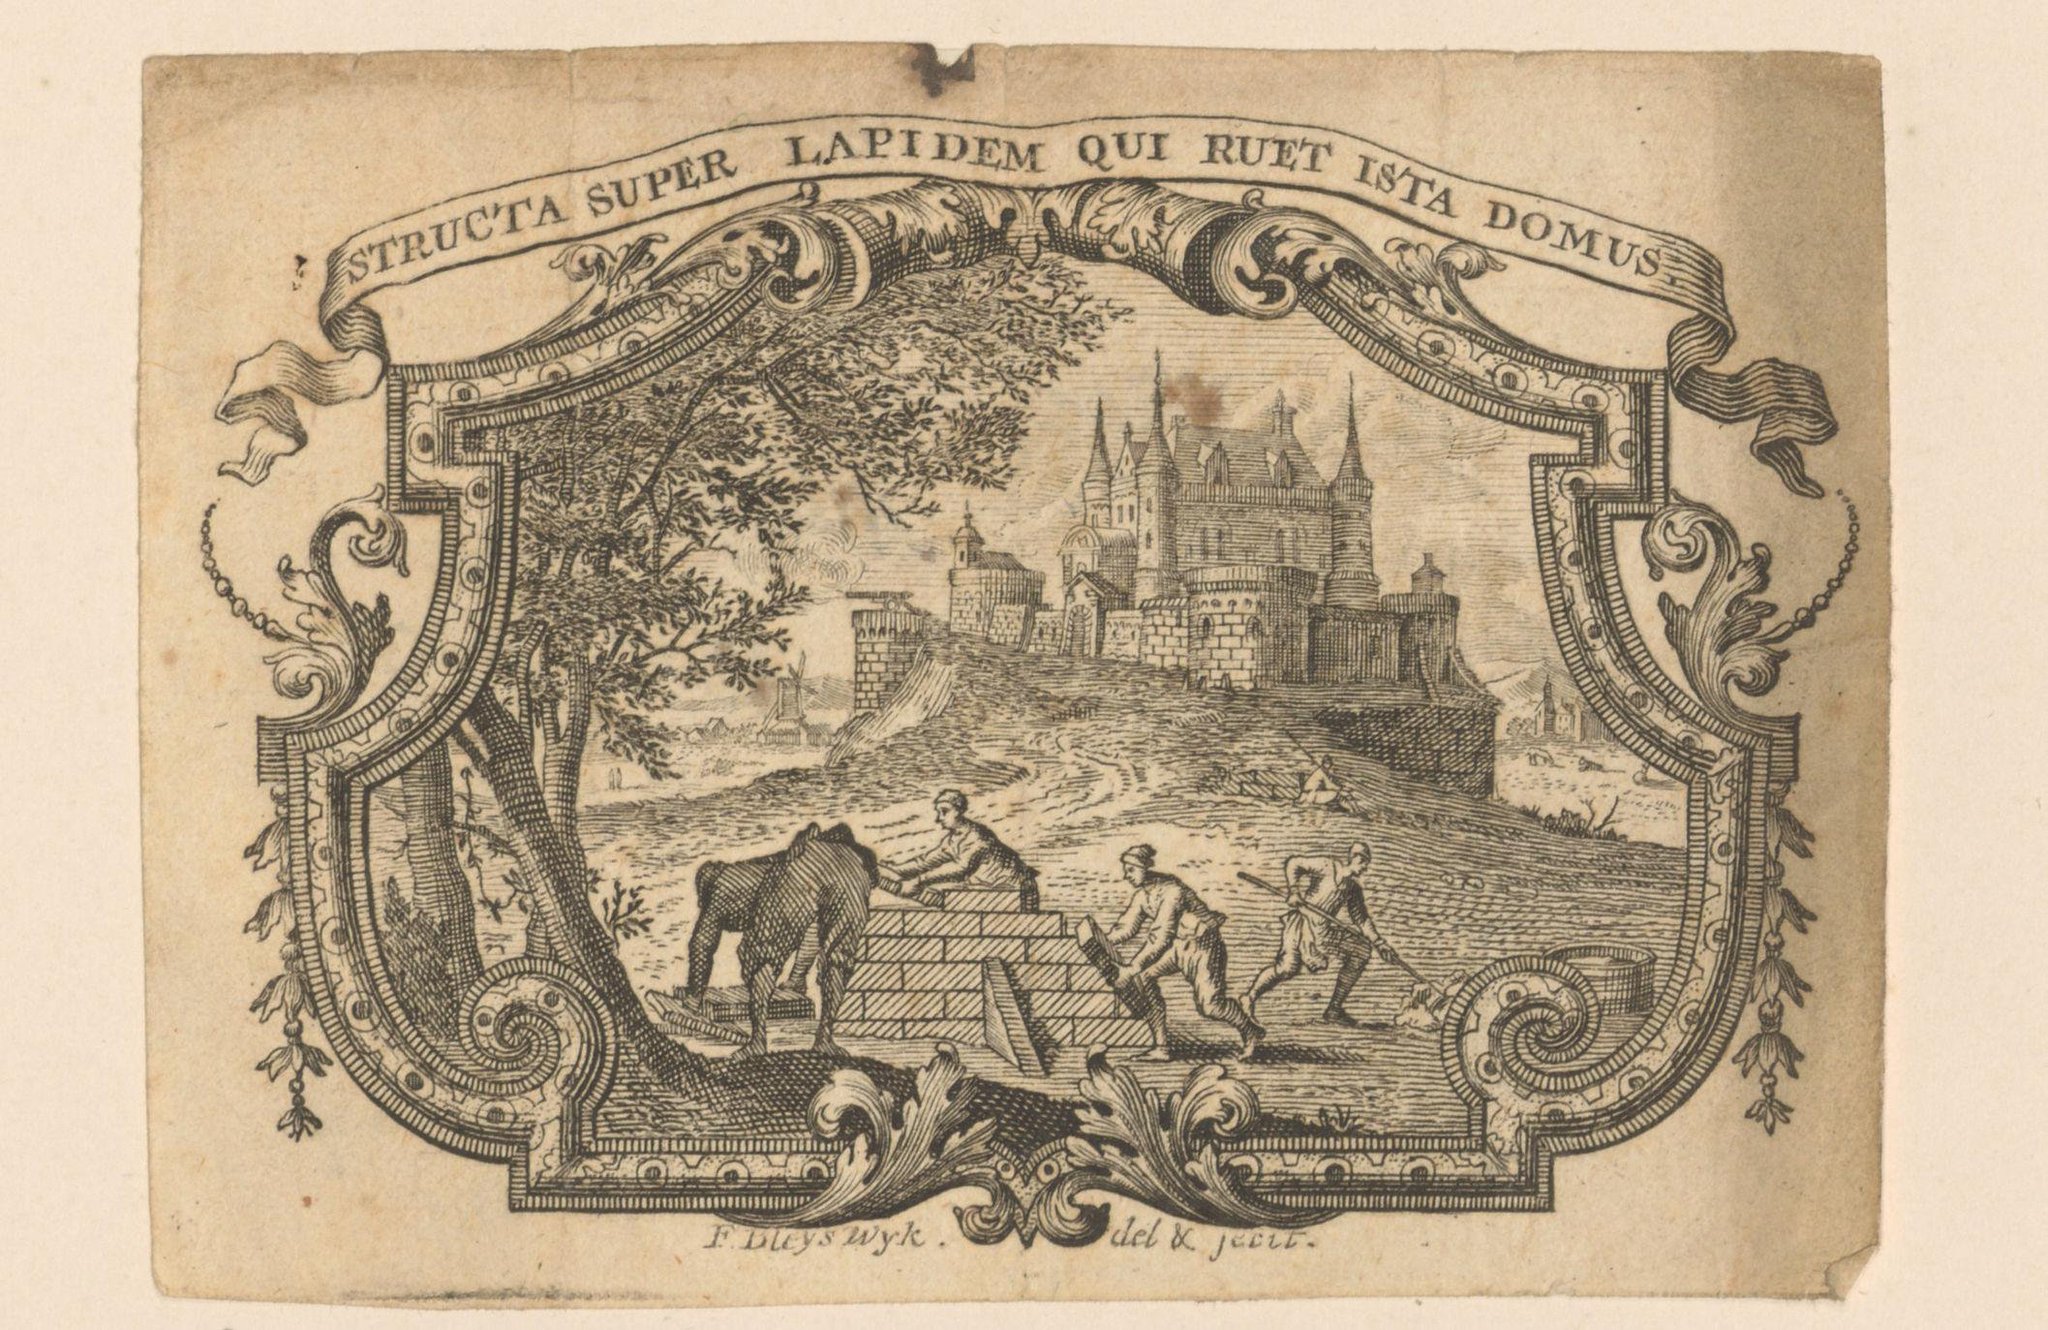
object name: bookplate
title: Structa super lapidem qui ruet ista domus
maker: f. bleyswyk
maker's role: print maker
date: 1700-1799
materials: paper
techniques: etching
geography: netherlands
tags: landscapes, castle, building-site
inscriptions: inscription: ‘[...] / A. van Westen van N. Verweij / 8 sept. 1849. [?]’